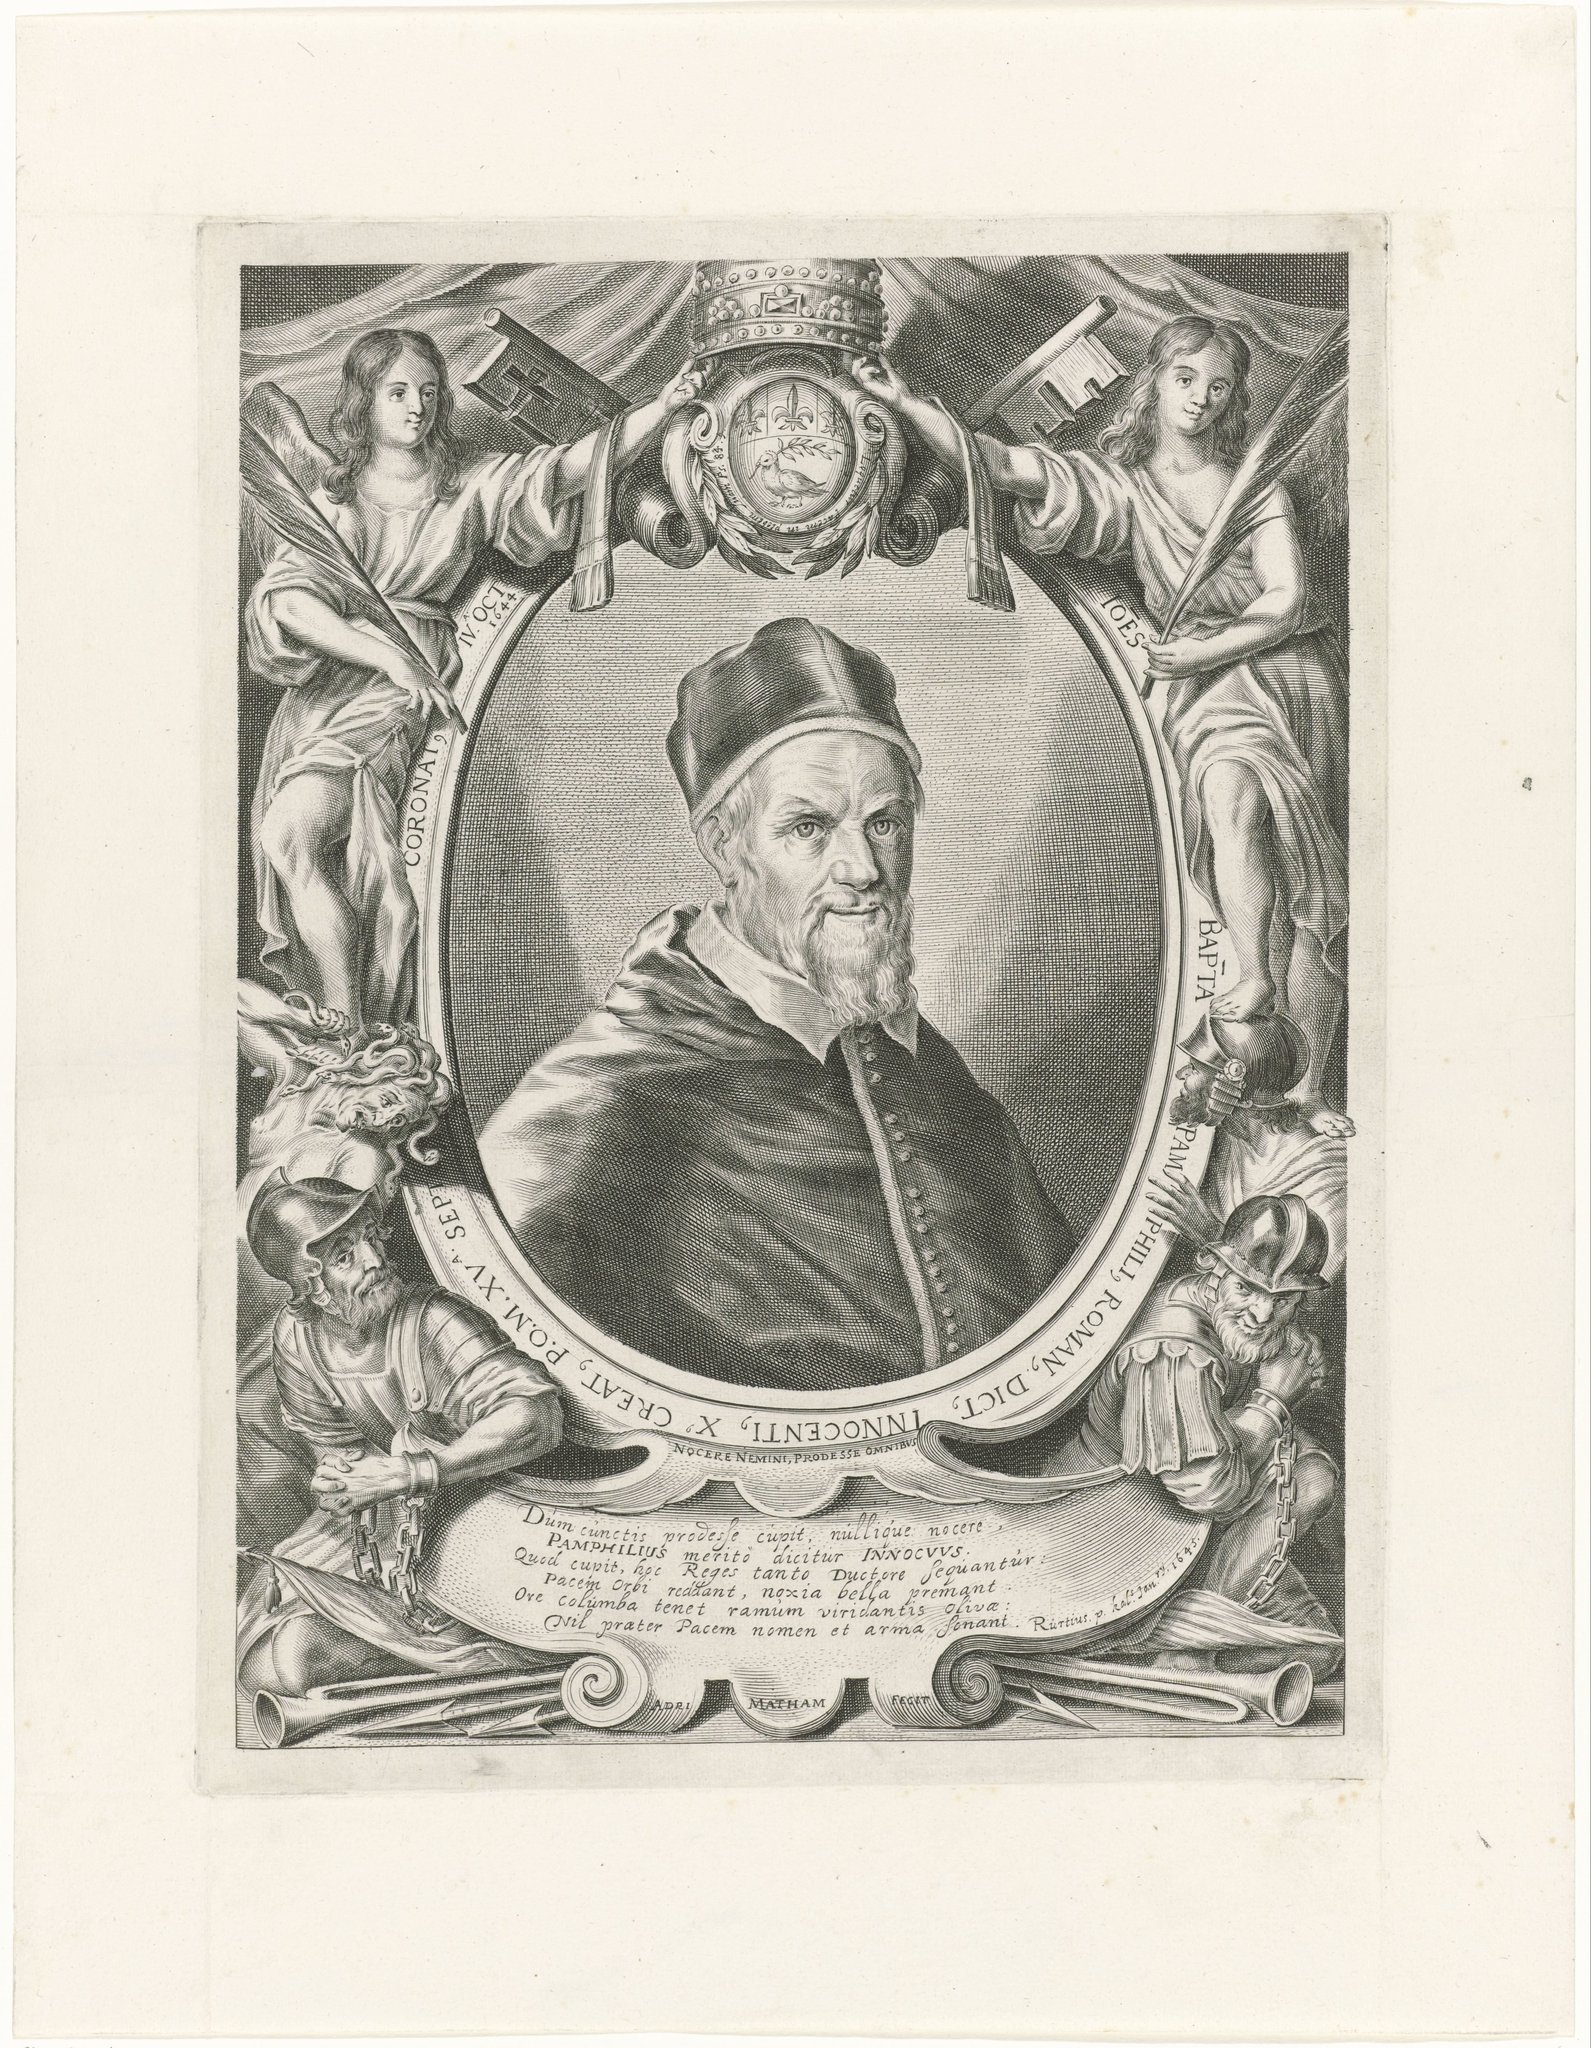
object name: print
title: Portret van paus Innocentius X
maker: adriaen matham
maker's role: draughtsman, print maker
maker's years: 1599-1660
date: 1645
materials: paper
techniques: engraving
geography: the hague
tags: rome, innocentius x, pope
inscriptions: collector's mark: Lugt 240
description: Portret van paus Innocentius X in een allegorische omlijsting, met bovenaan twee engelen die een pauselijke tiara vasthouden.